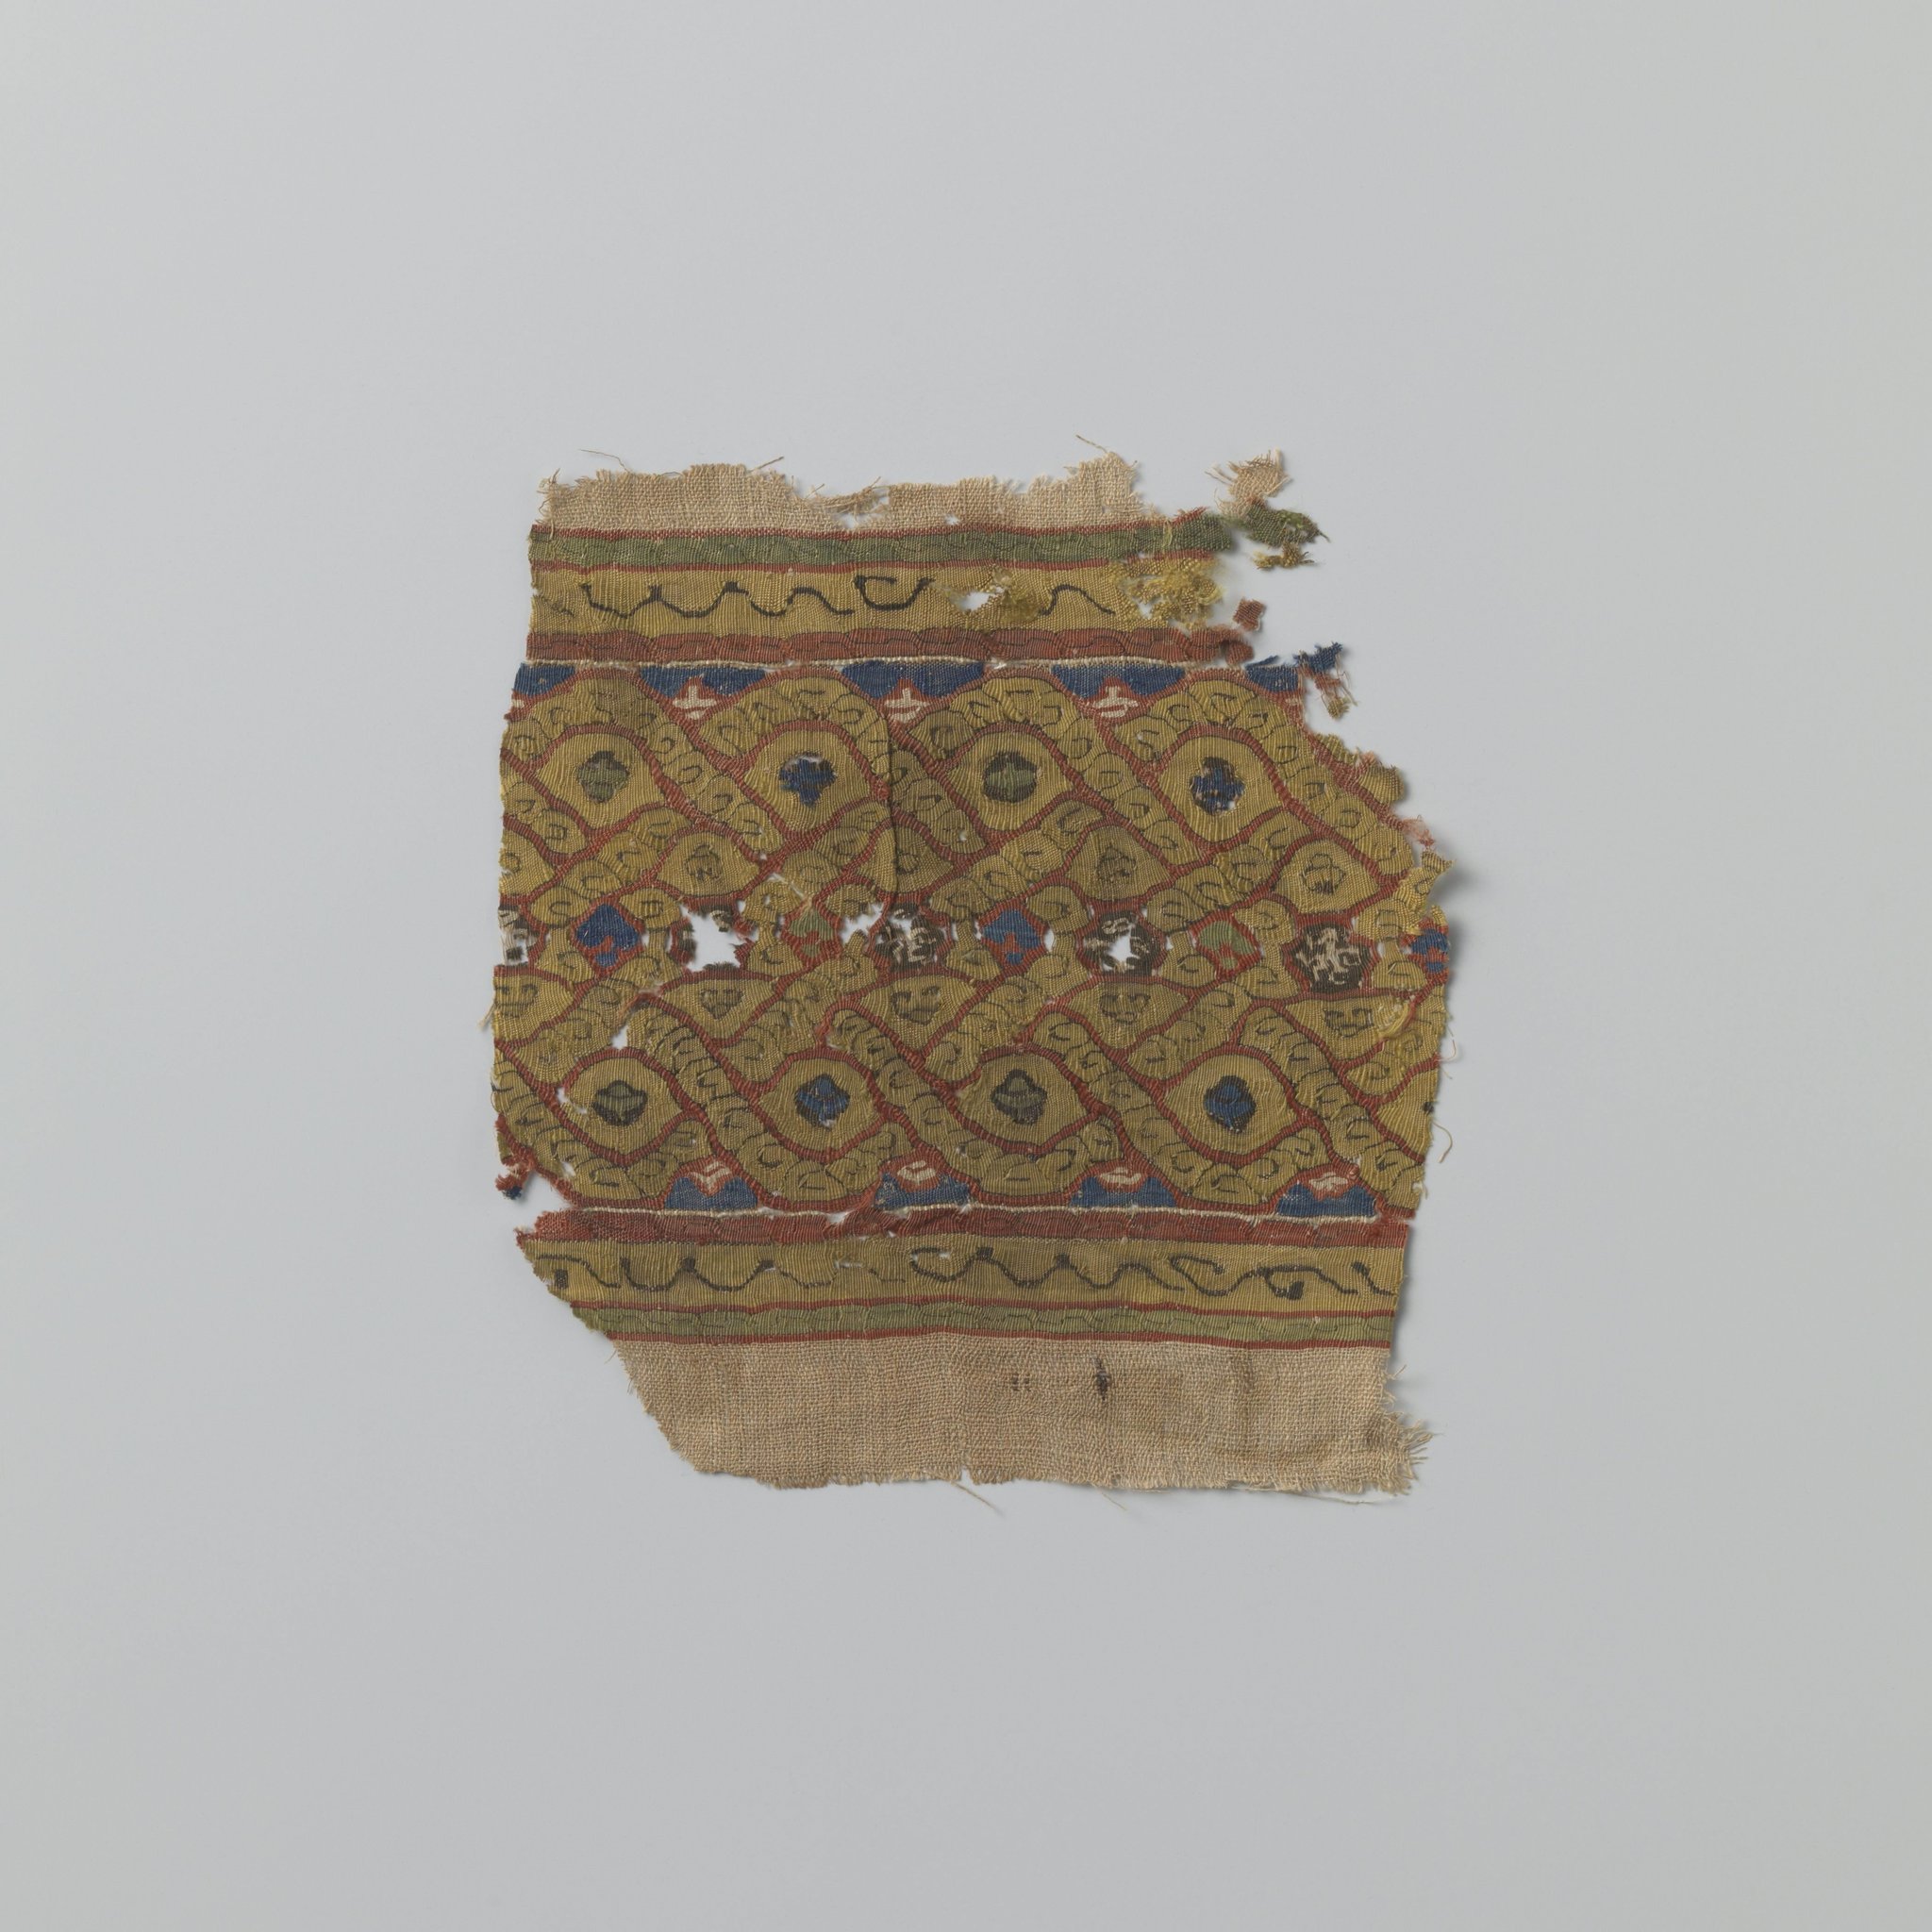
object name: fragment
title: Weefselfragment met decoratieve band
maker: Anonymous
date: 1100-1199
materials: linen, silk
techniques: weave, tapestry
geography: germany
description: Naturelkleurig linnen weefselfragment met decoratieve band met vlechtbandmotieven en hazen in tapijtwerk.